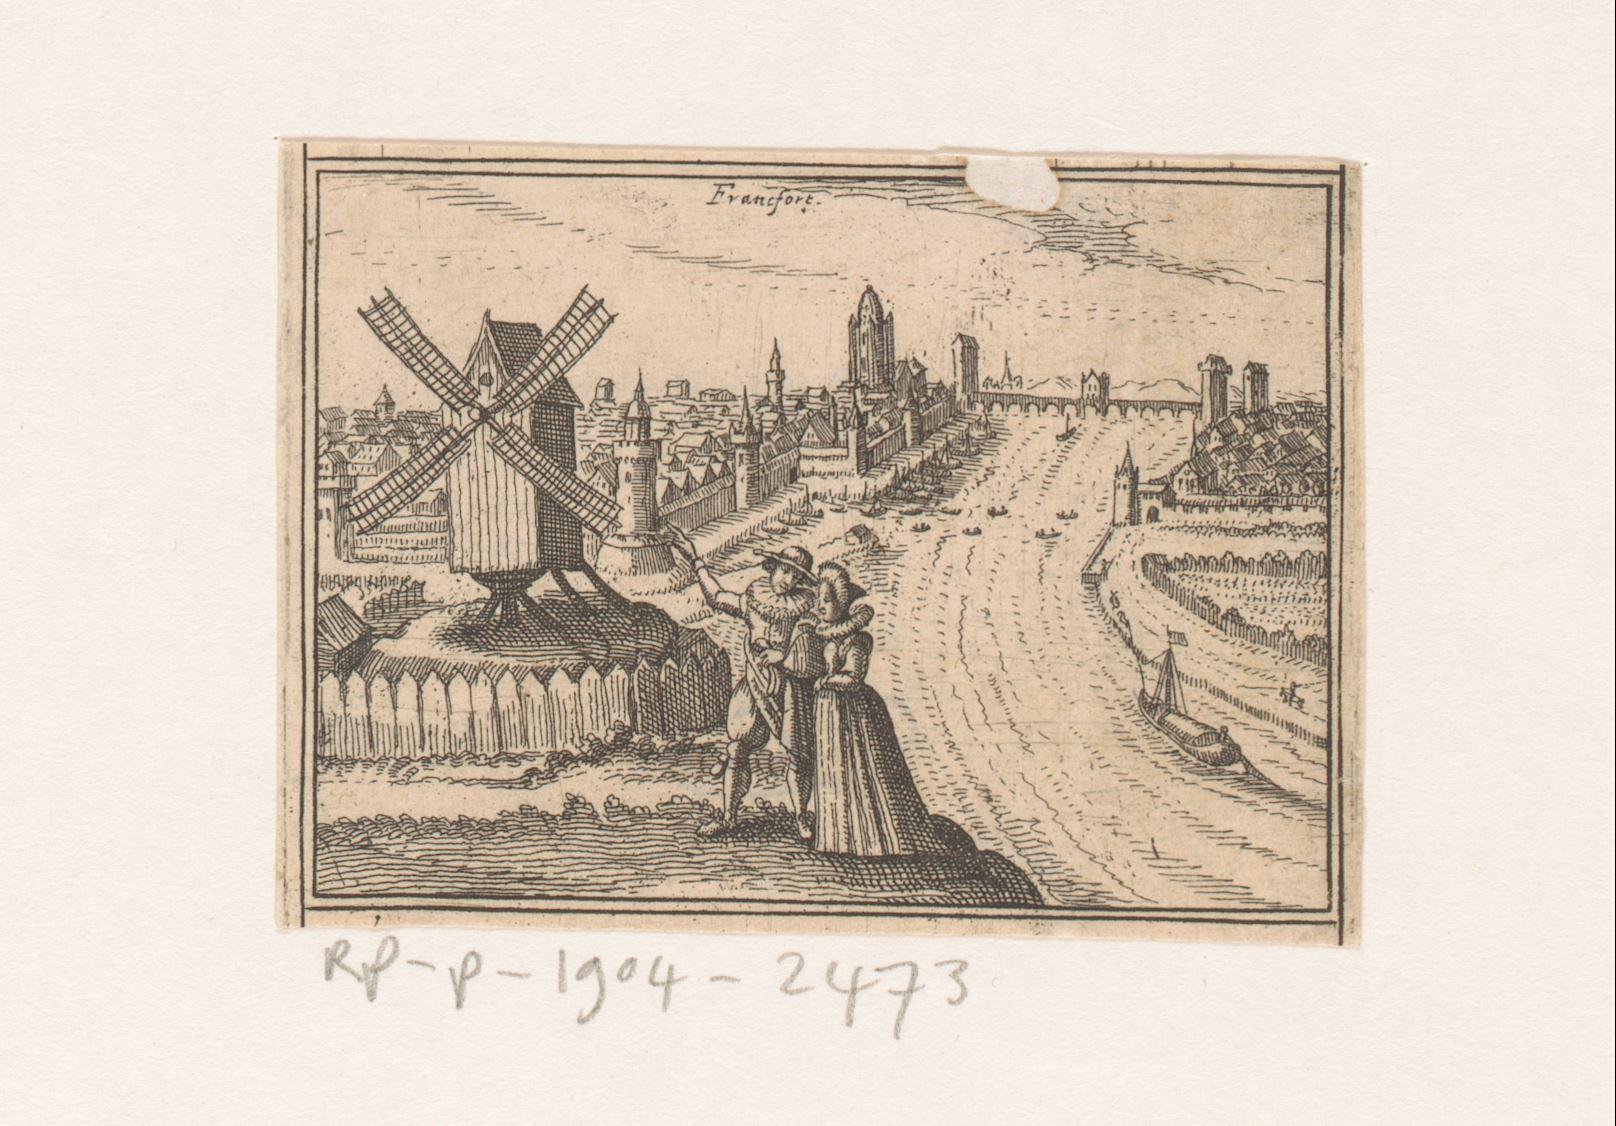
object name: book illustration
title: Francfort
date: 1624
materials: paper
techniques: etching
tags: city-view, and landscape with man-made constructions, windmill, arm in arm (lovers)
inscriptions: collector's mark: Lugt 2228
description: Prent uit: Sudermann, Daniel. Centuria Similitudinum, Hubert Gleichnussen. Straatsburg, Jacob van der Heyden, 1624. (Hollstein German XXVIA 646).